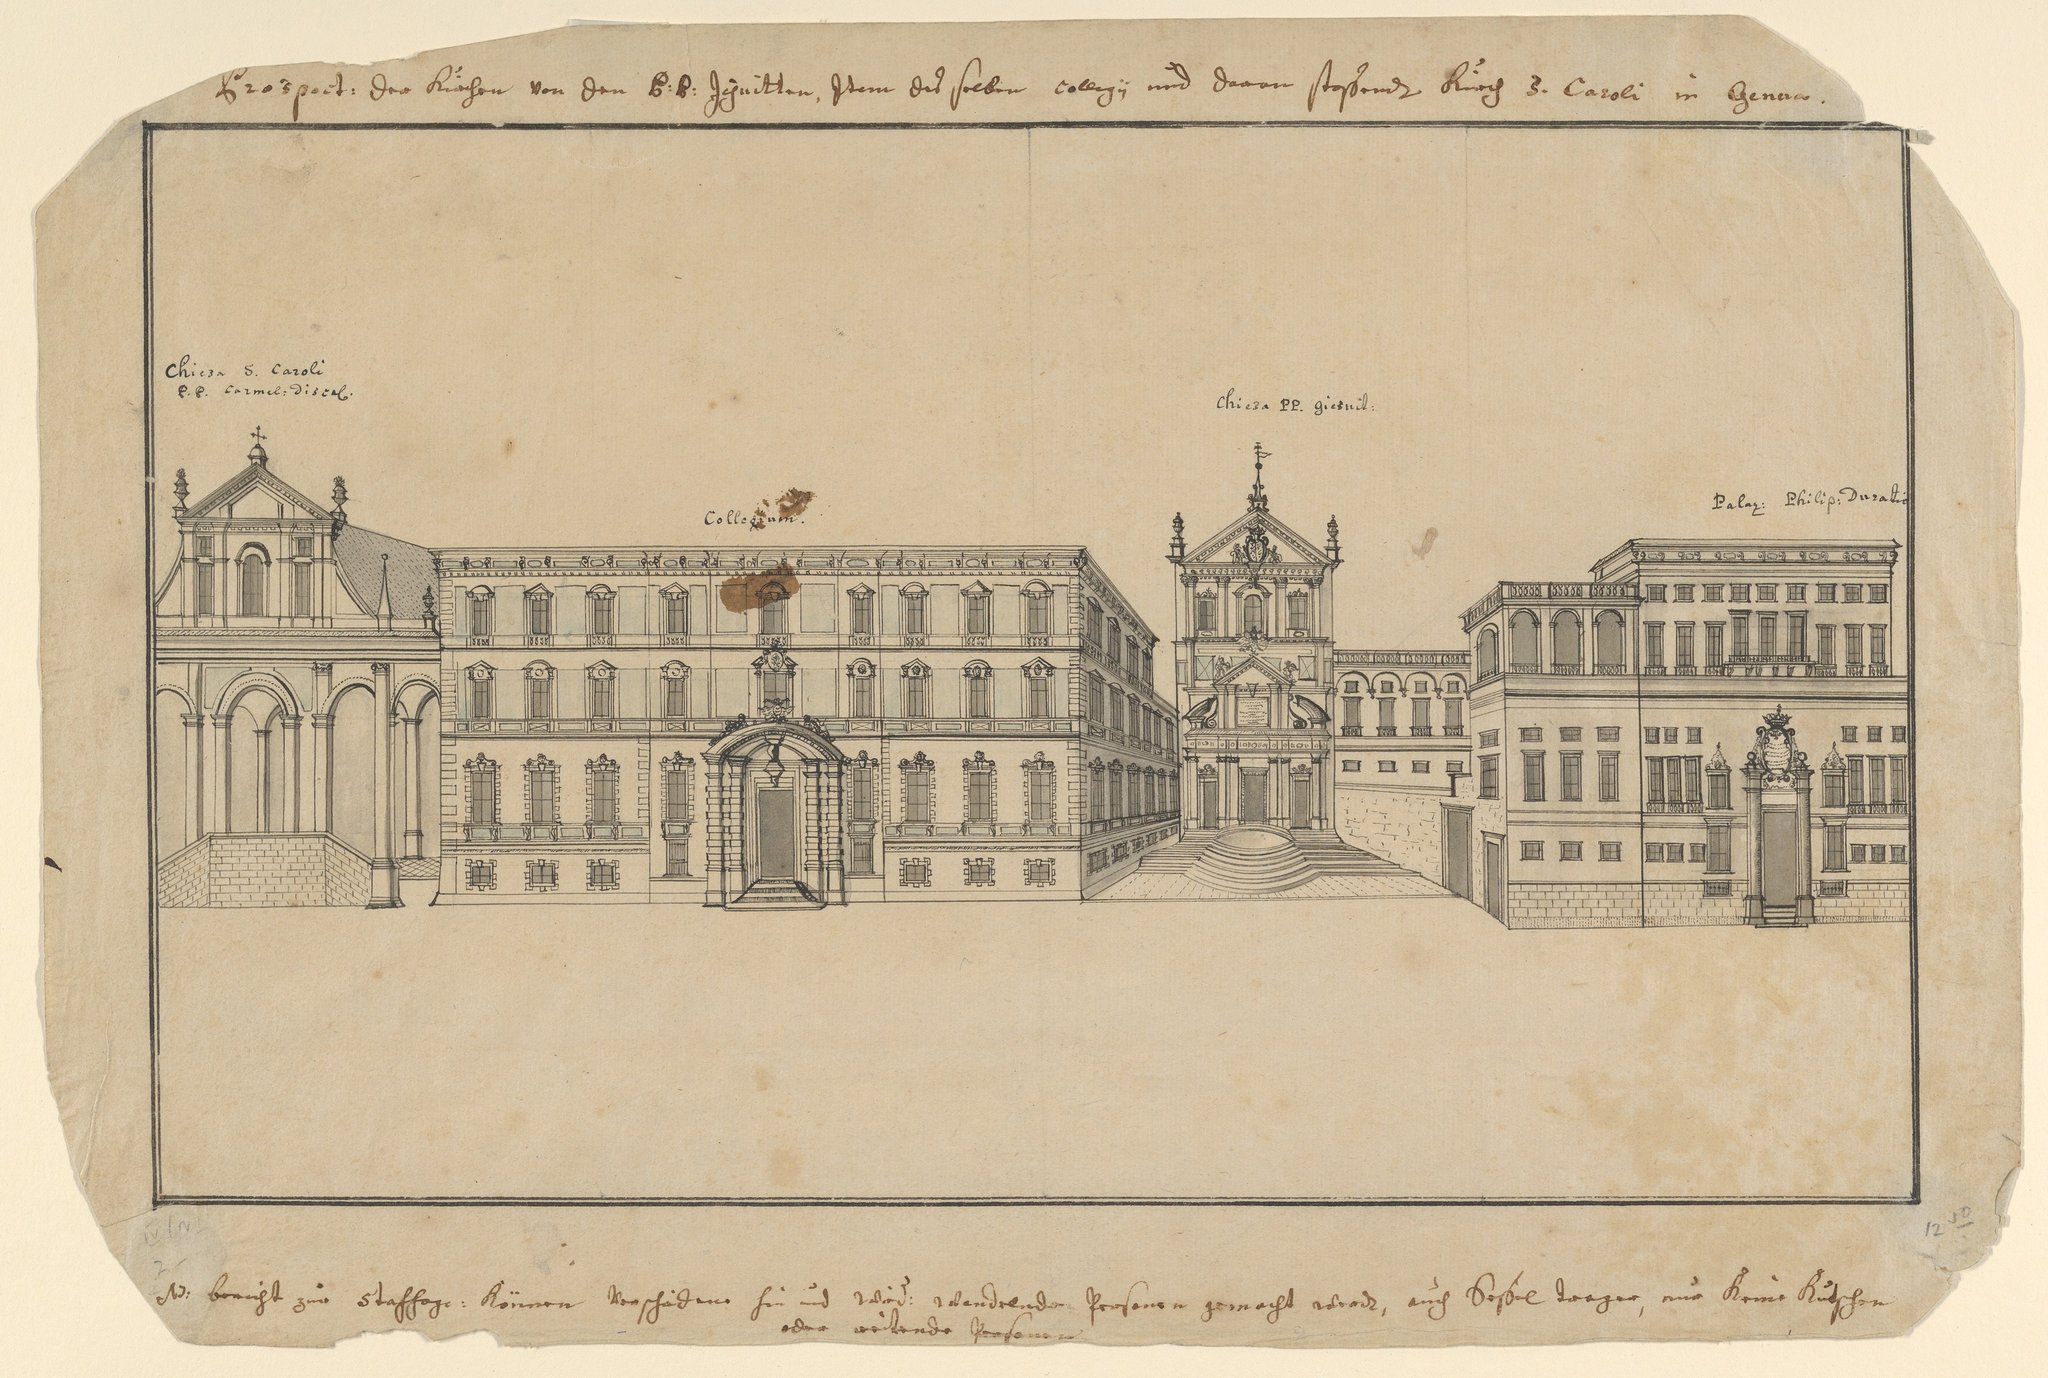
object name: drawing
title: View of Via Balbi in Genoa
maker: anonymous, italian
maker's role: artist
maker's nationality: italian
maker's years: 1400-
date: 1650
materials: ink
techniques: drawing, pen, wash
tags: architecture,buildings